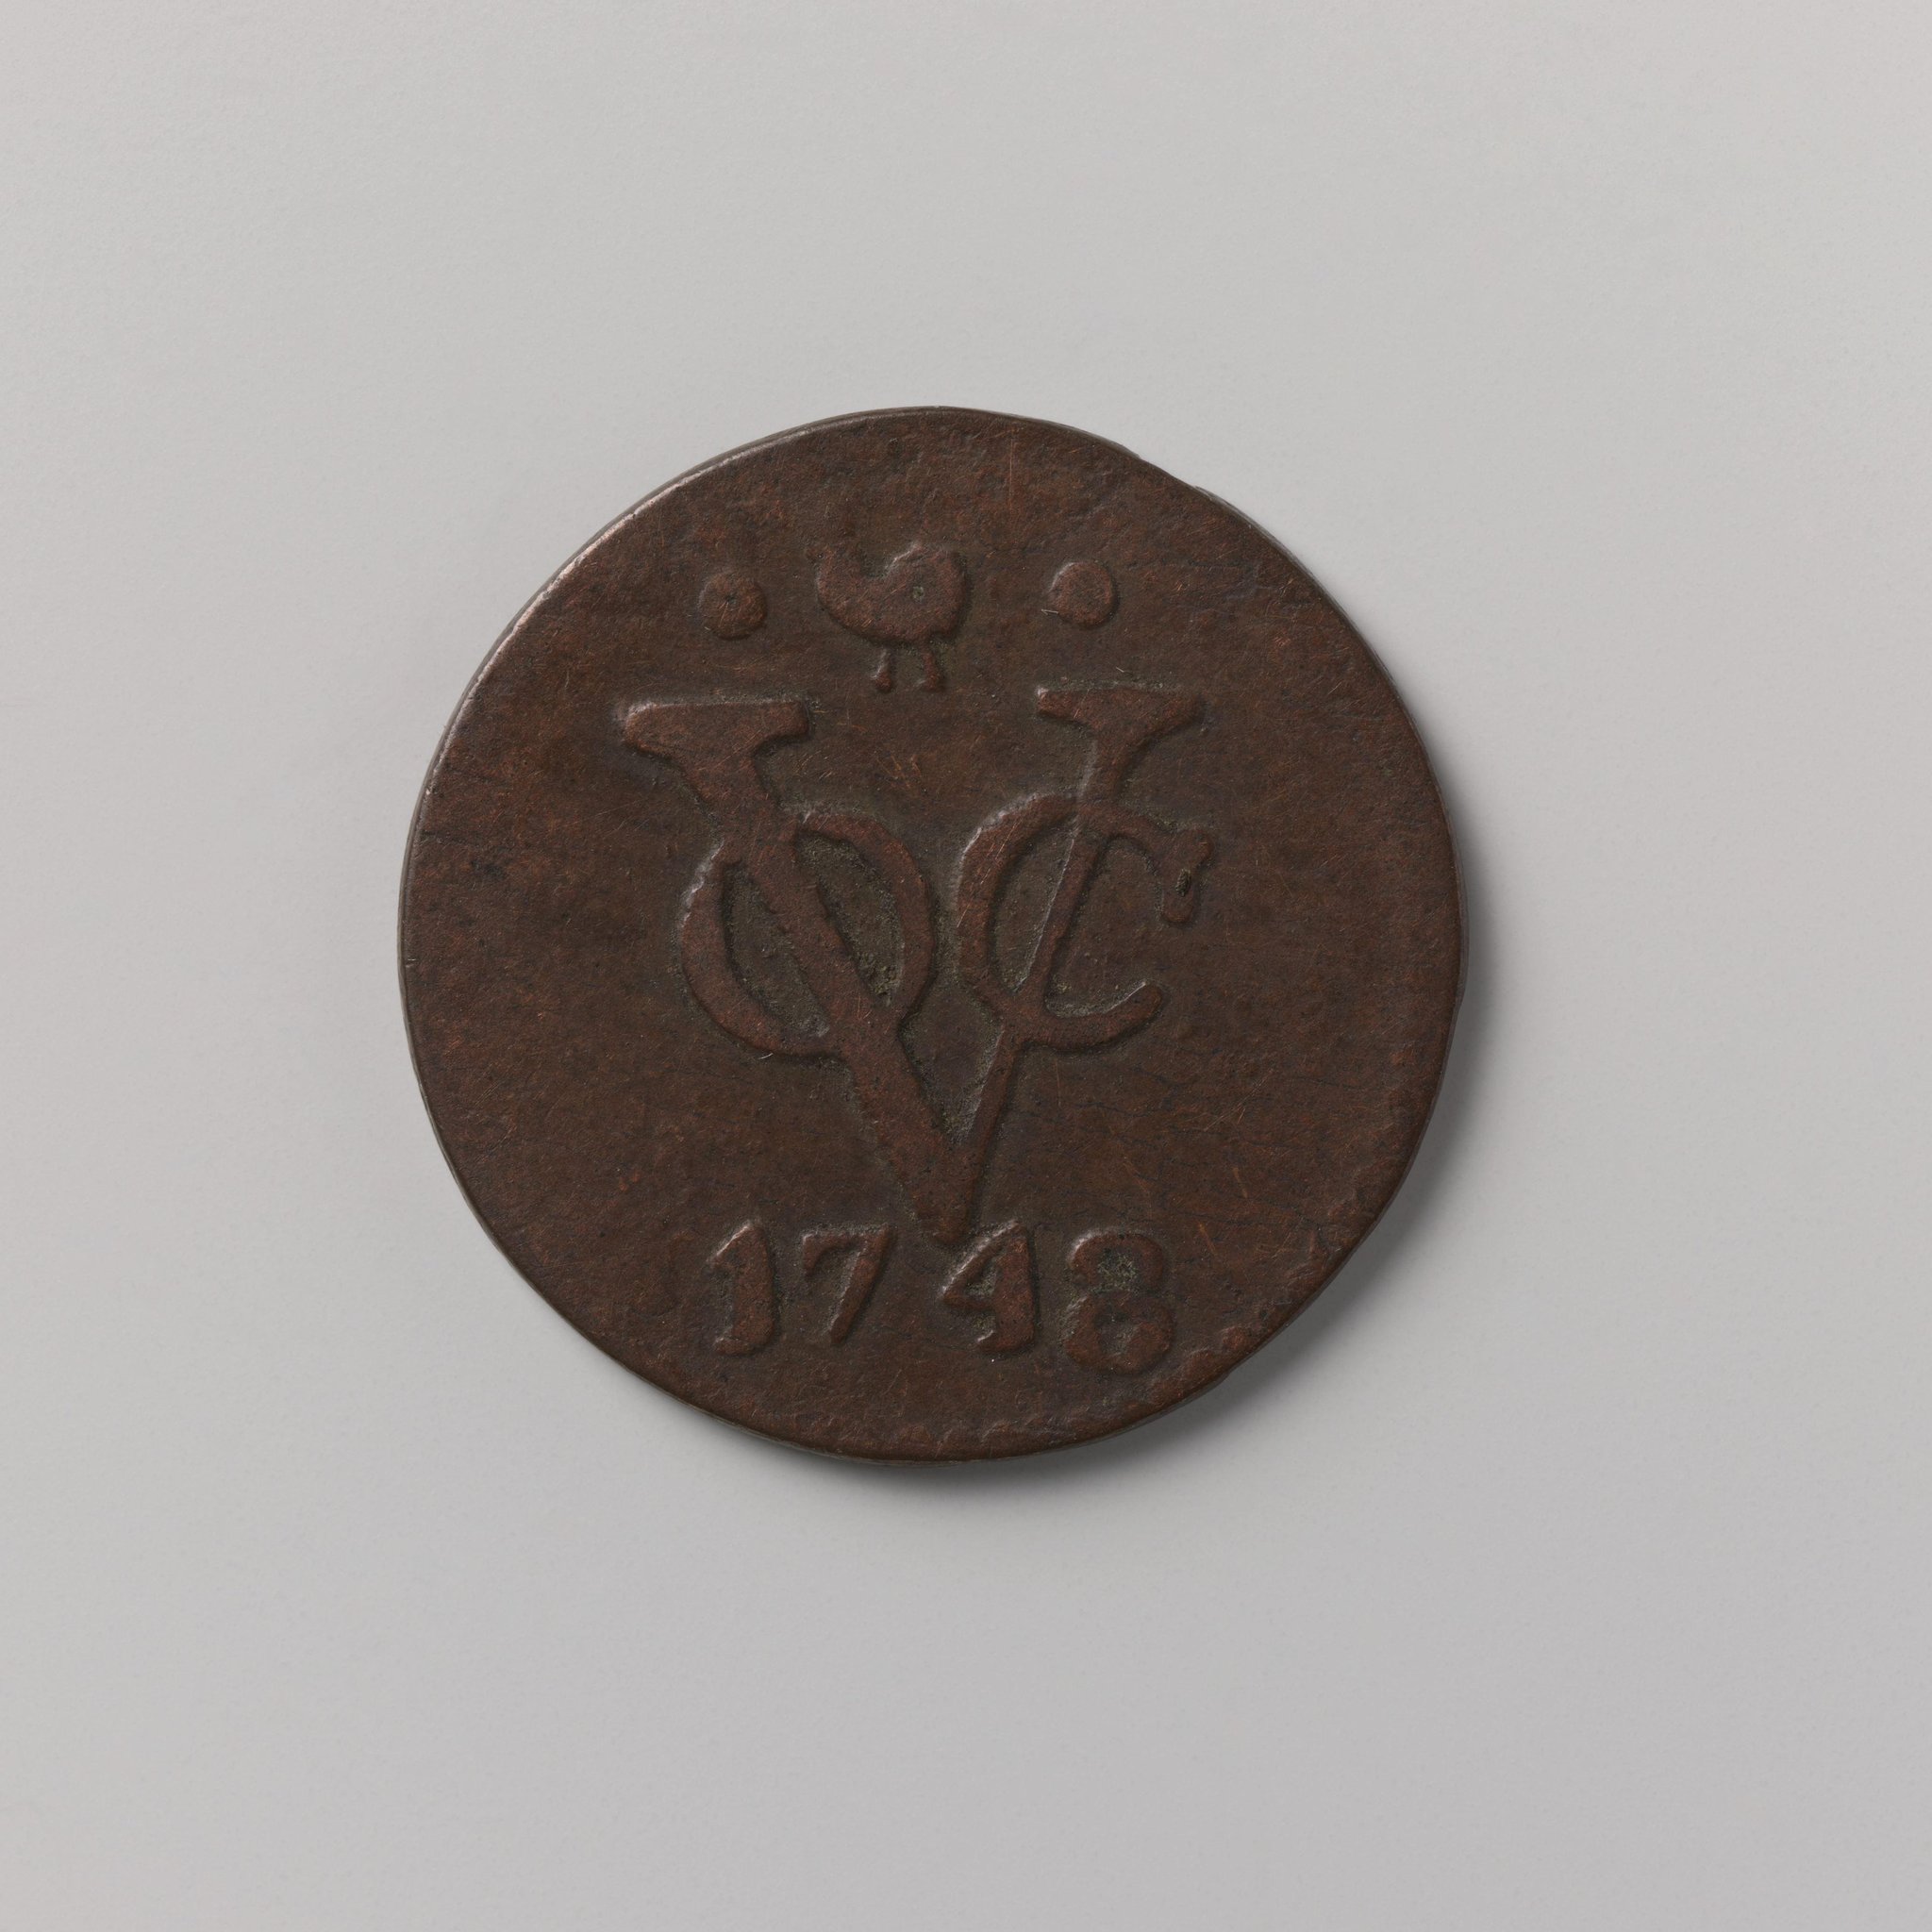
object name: coin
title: VOC, duit Westfriesland, 1748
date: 1748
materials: copper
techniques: striking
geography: medemblik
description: Koperen munt. Voorzijde: gekroond wapenschild van Westfriesland. Keerzijde: monogram van de VOC, waarboven muntmeesterteken en waaronder jaartal. Gladde rand.